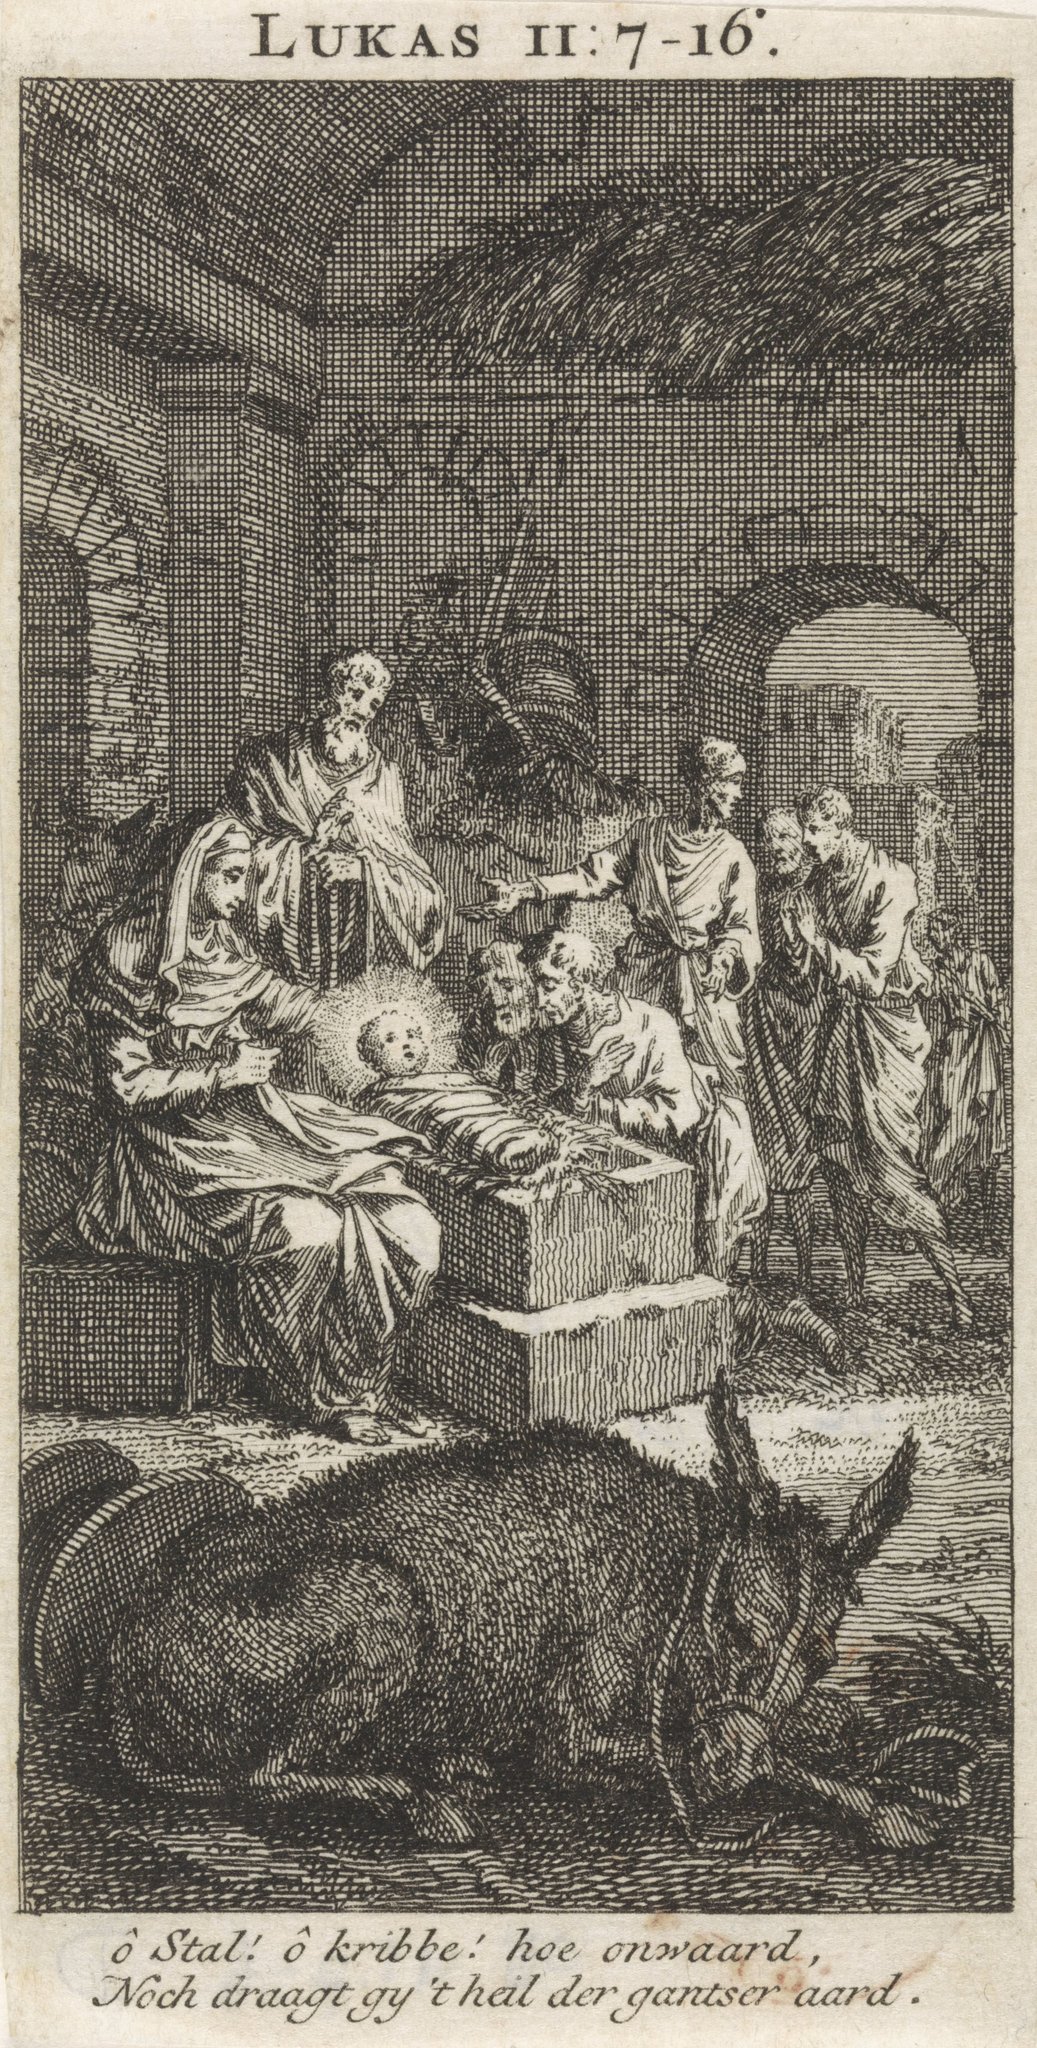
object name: print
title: Aanbidding der Herders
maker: Anonymous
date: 1712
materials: paper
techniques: etching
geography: amsterdam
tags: adoration of the christ-child by the shepherds; mary and joseph present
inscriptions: collector's mark: Lugt 240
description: Kopie naar illustratie voor: Luyken, Jan. Bybel printen. Amsterdam: Pieter Arentsz. II (wed.) en Cornelis van der Sys, 1712, p. 25.